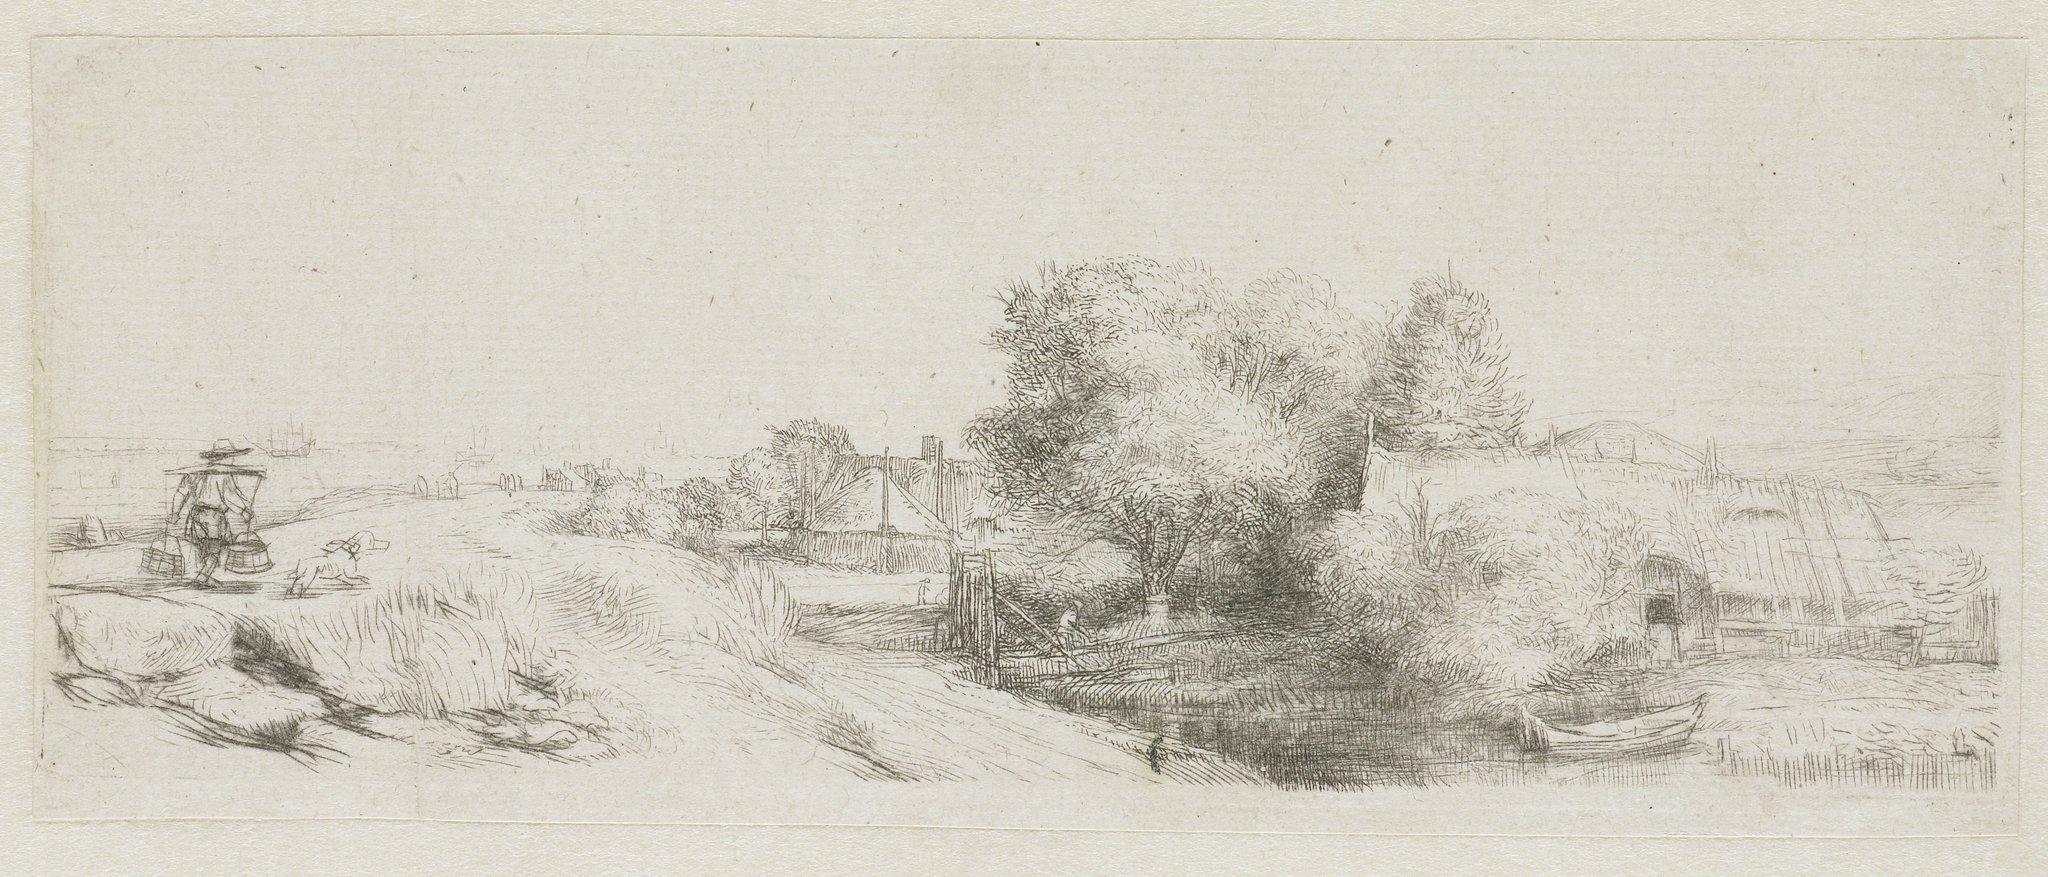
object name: print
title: View of the Diemerdijk with a milkman and cottages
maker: rembrandt van rijn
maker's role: draughtsman, painter, print maker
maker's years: 1606-1669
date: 1650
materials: paper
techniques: printmaking, drypoint, etching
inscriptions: collector's mark: Lugt 240